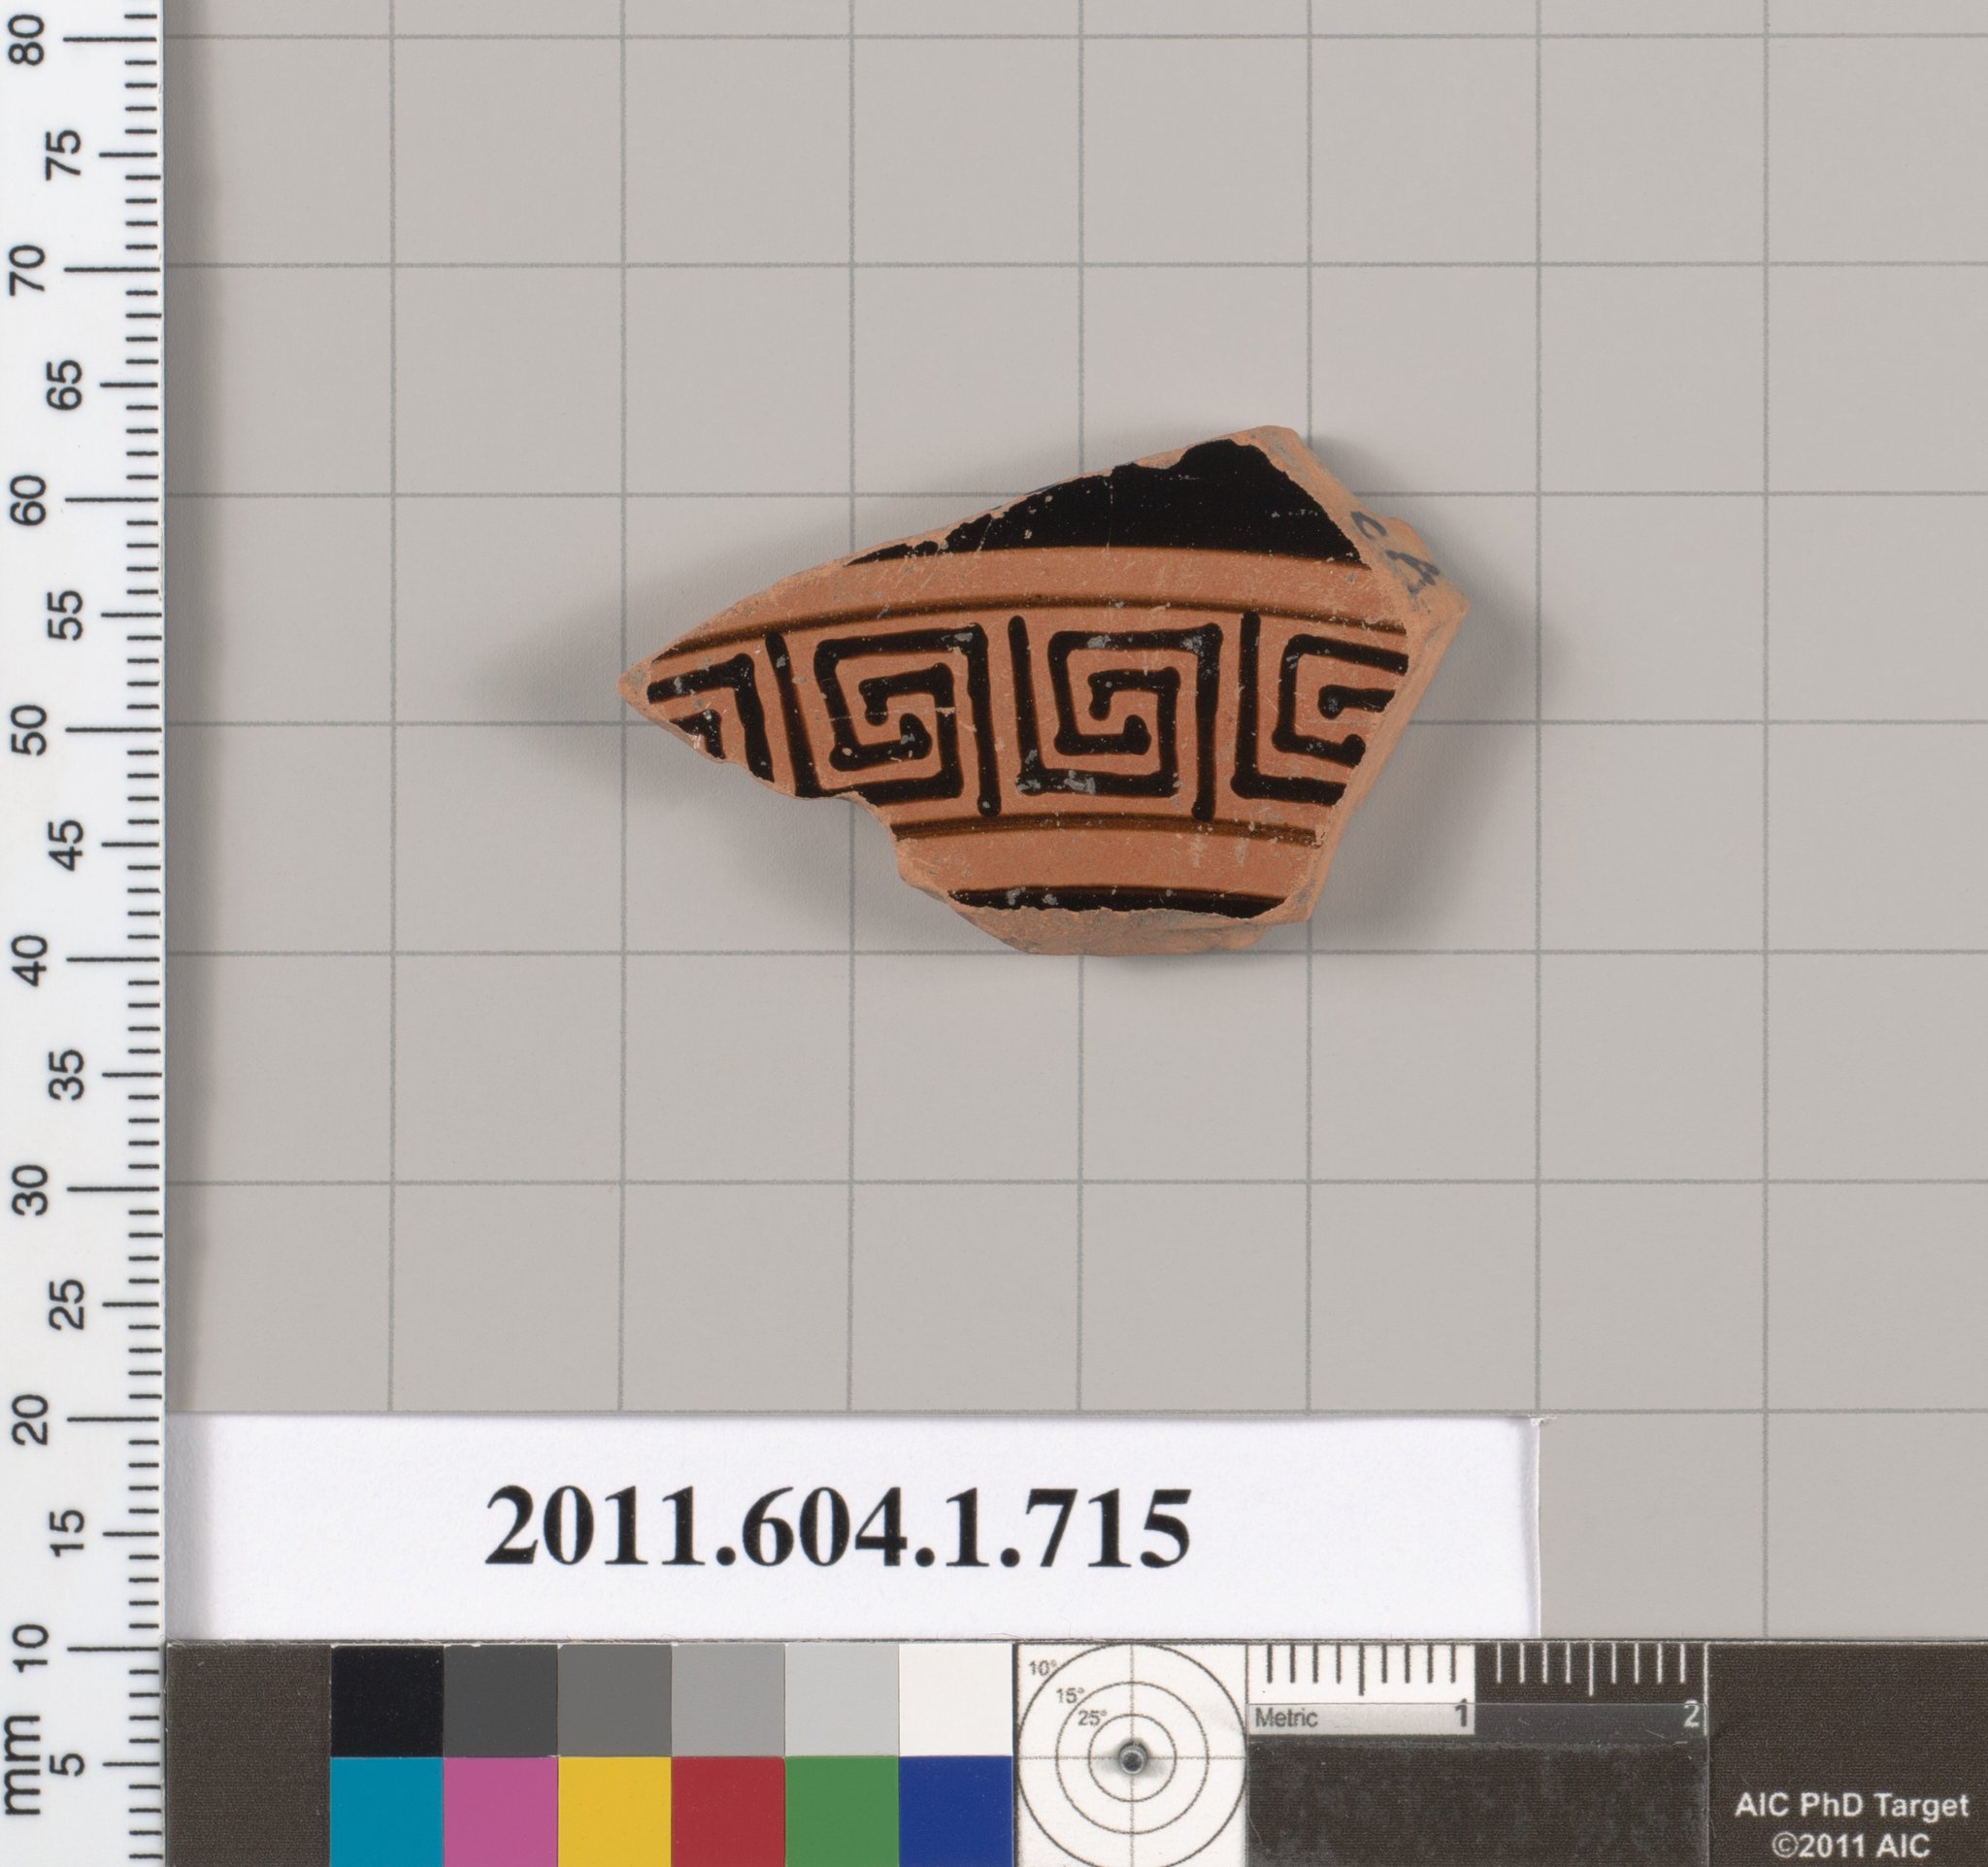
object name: kylix fragment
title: Terracotta fragment of a kylix (drinking cup)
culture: greek, attic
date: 475-451 BCE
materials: terracotta